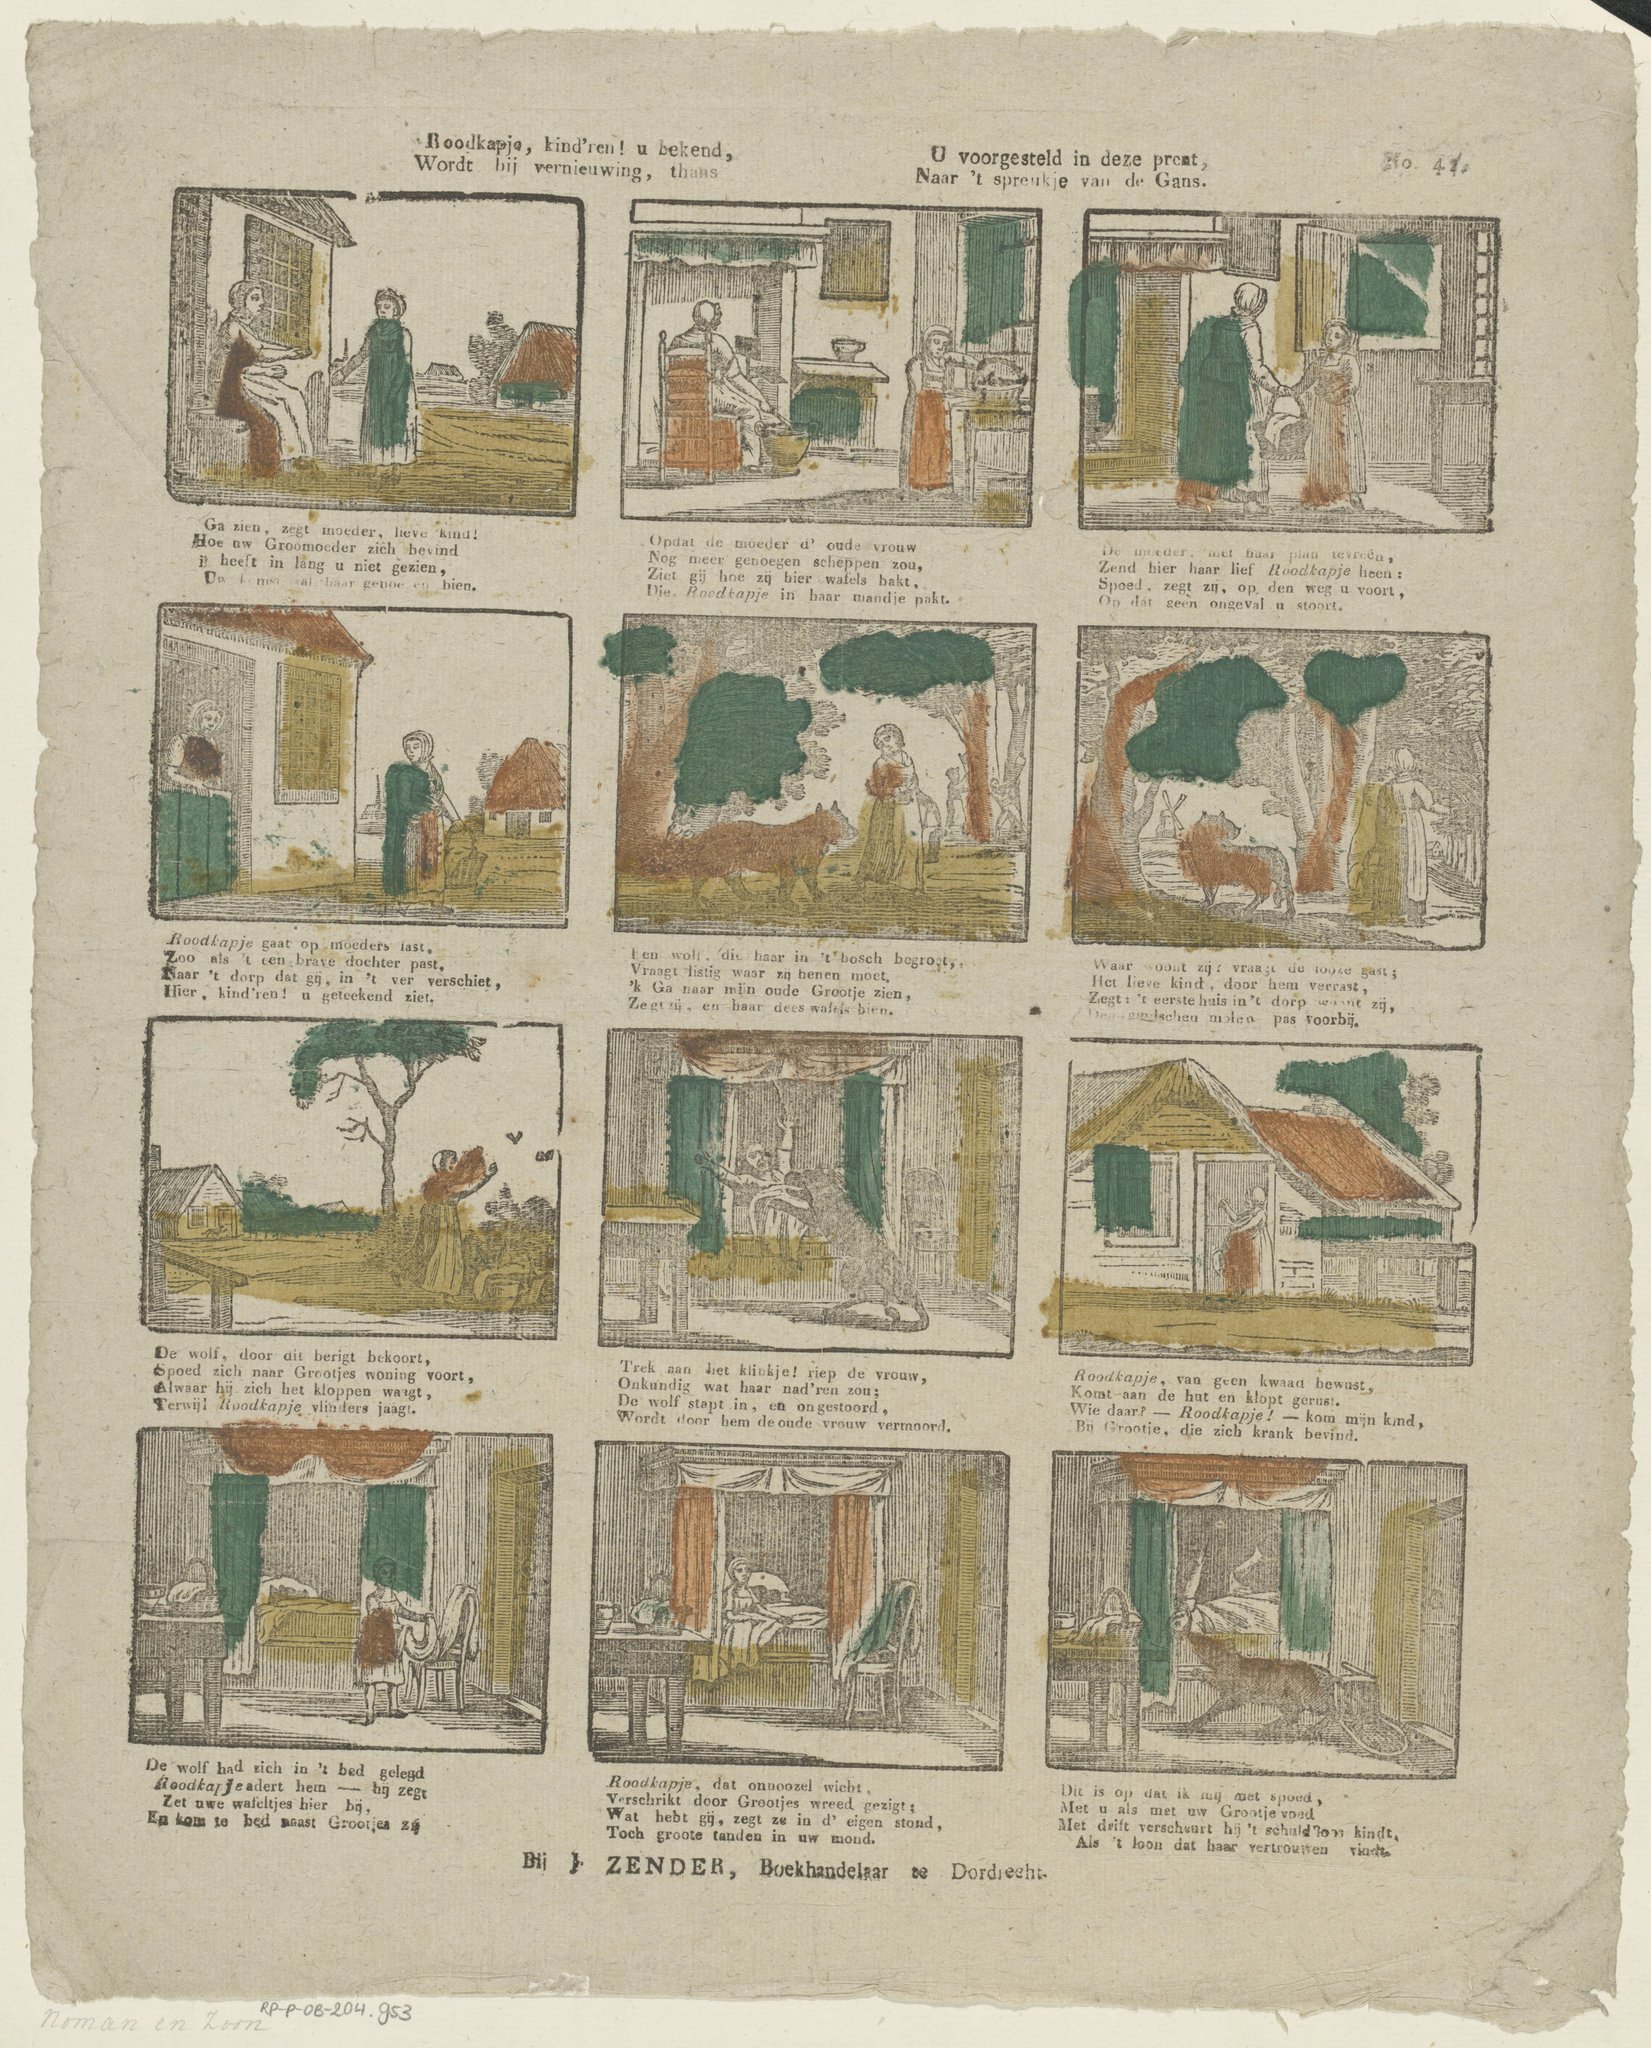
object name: popular print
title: Roodkapje, kind'ren! u bekend, / Wordt bij vernieuwing, thans / U voorgesteld in deze prent, / Naar 't spreukje van de gans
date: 1830-1892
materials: paper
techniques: colour, letterpress printing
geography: zaltbommel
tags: tales and fairy tales: little red riding-hood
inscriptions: collector's mark: Lugt 2760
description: Blad met 12 voorstellingen uit het sprookje van Roodkapje. Onder elke afbeelding een vierregelig vers. Genummerd rechtsboven: No. 41.